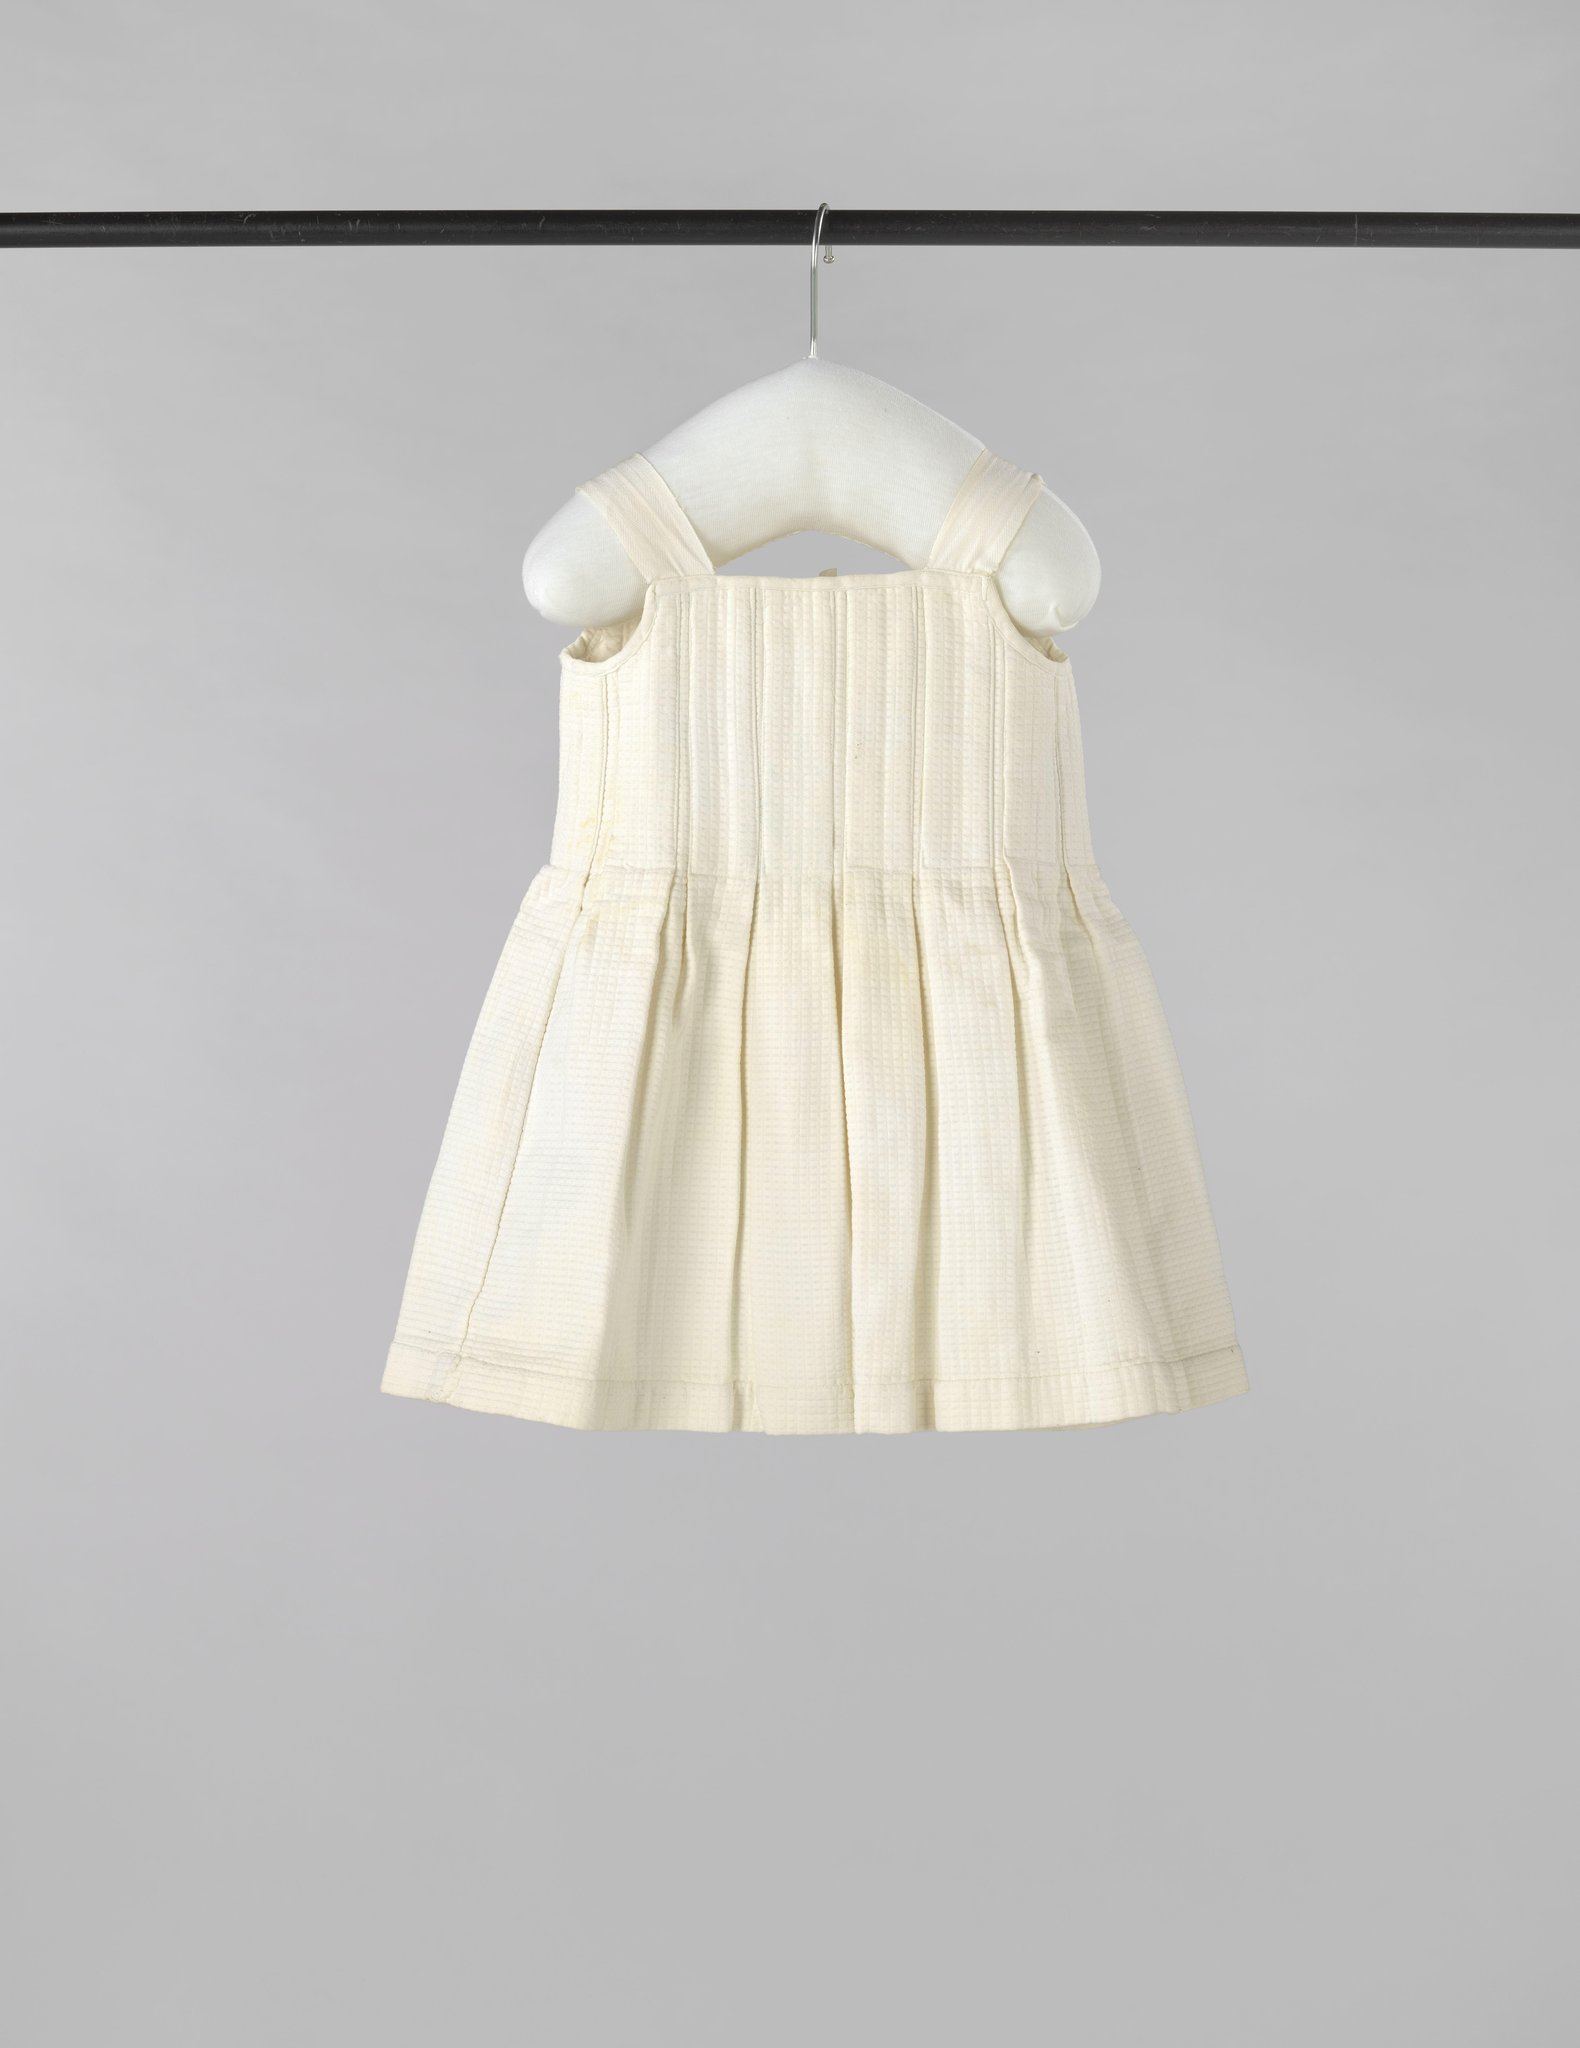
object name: slip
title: Onderjurk met achtersluiting met striklinten van wit piqué met wafeltjespatroon; merkbandje: V.E.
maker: Anonymous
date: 1905-1910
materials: cotton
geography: netherlands